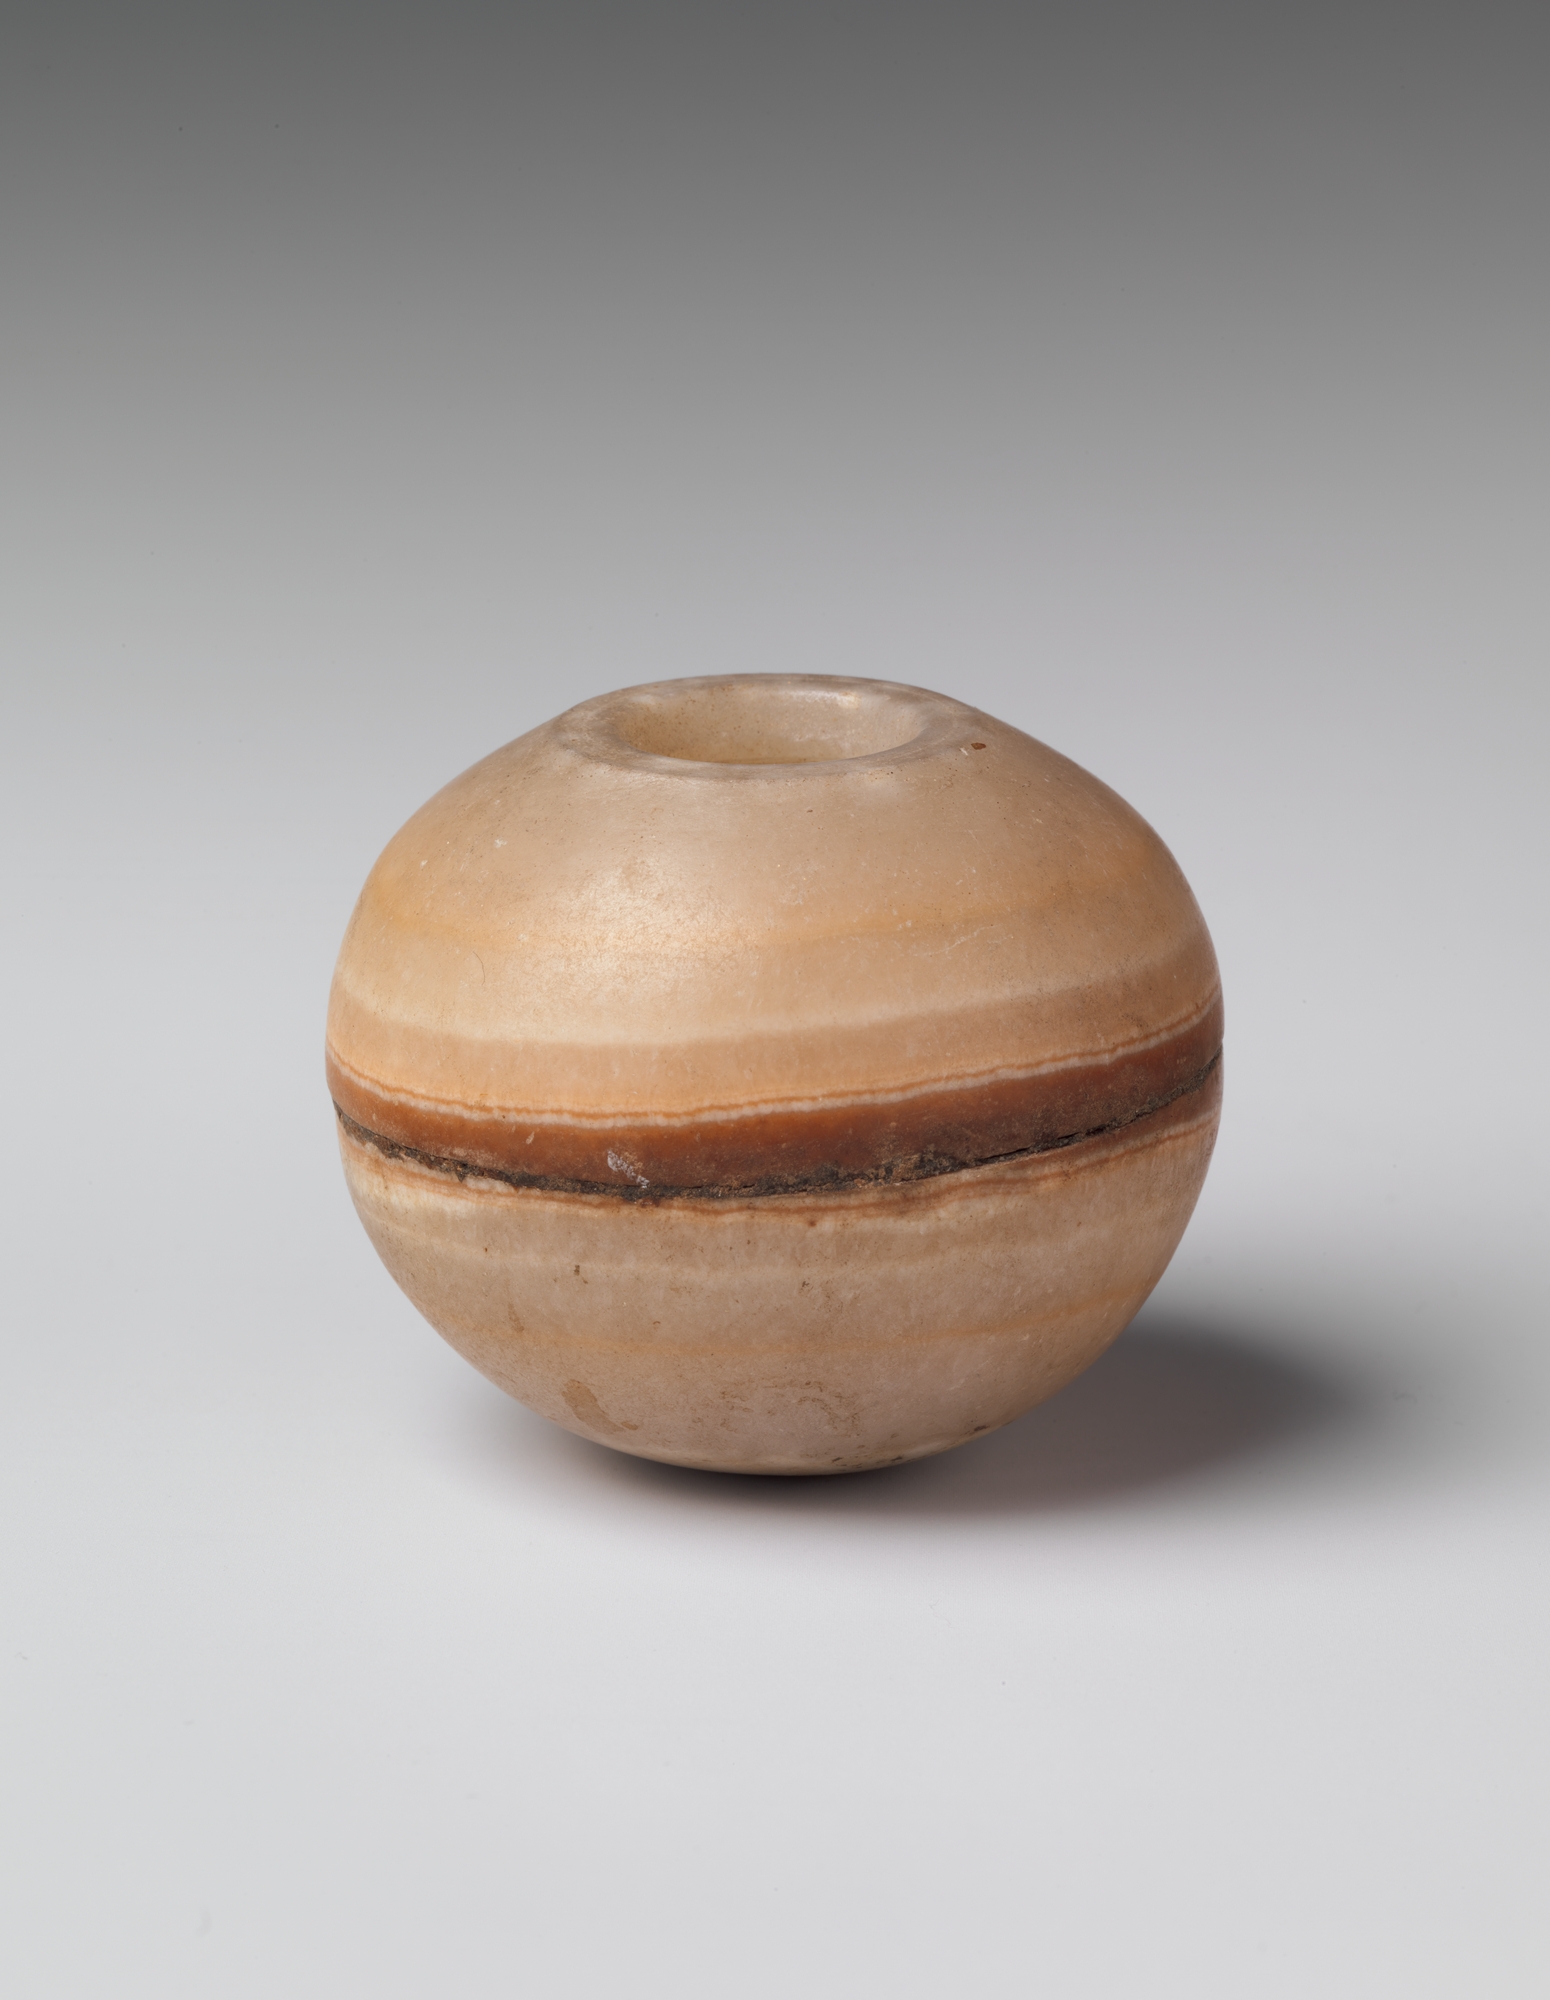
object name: cosmetic jar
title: Toilet jar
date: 1981-1802 BCE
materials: stone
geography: egypt